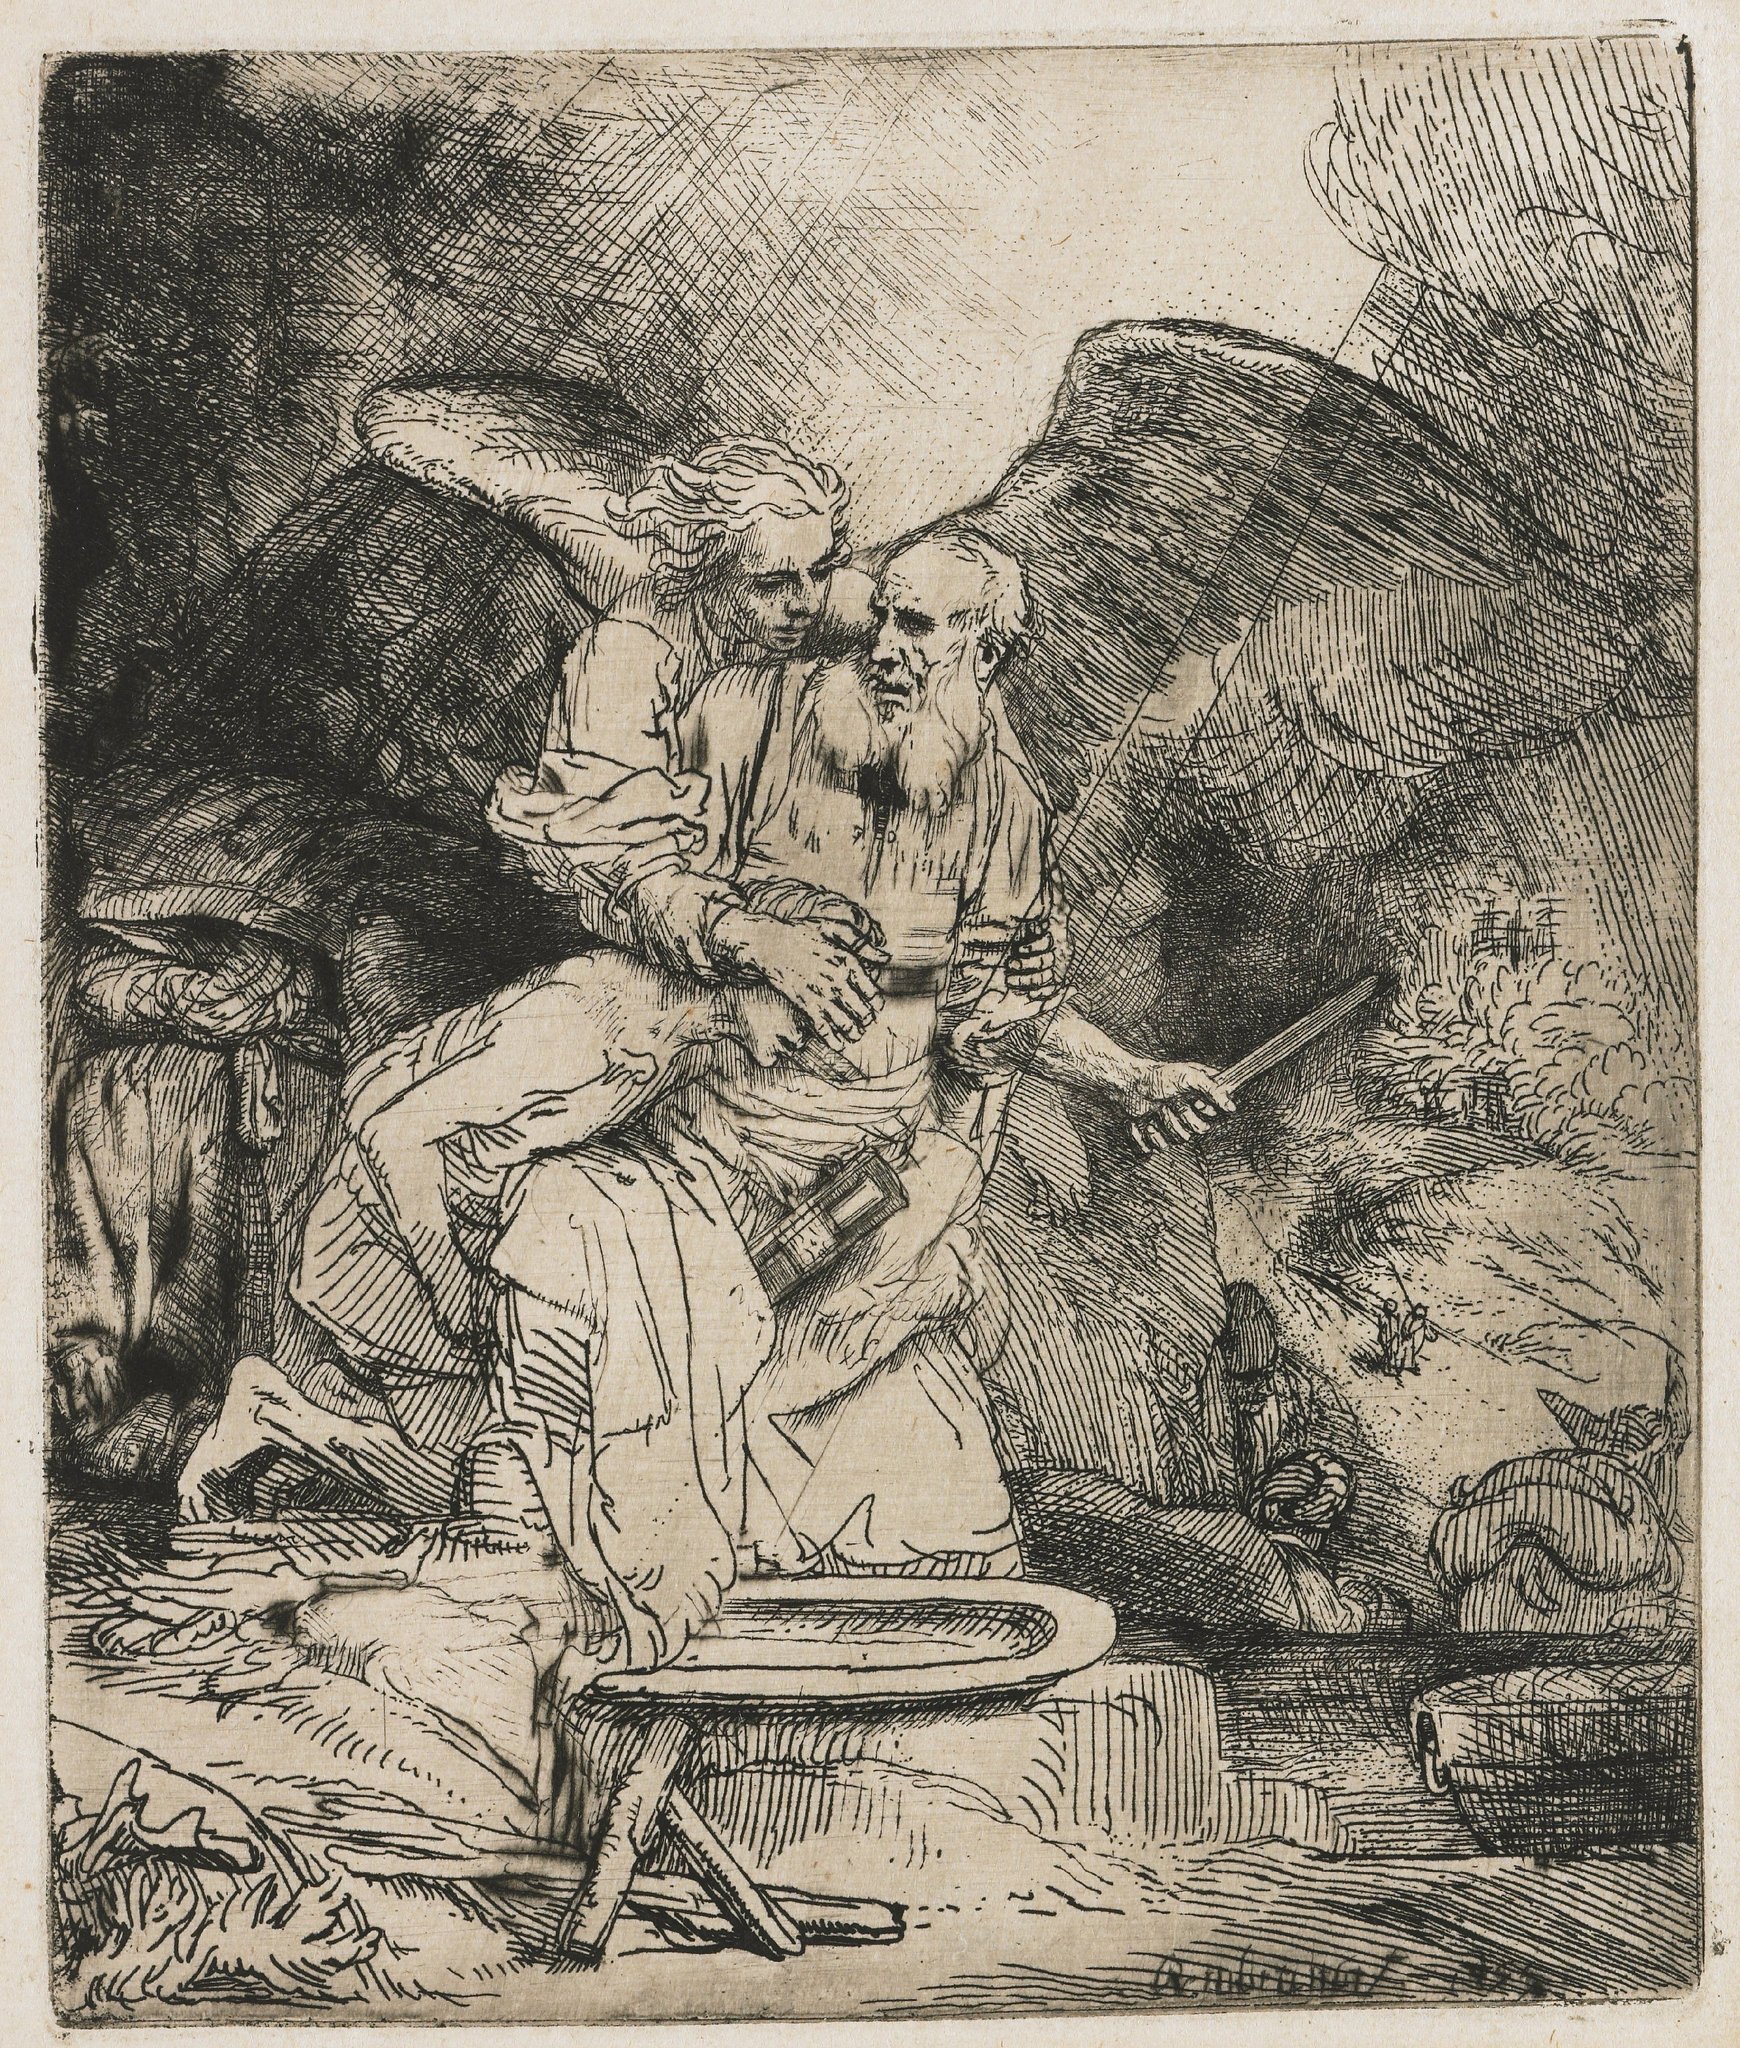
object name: print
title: Abraham's sacrifice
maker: rembrandt van rijn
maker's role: draughtsman, painter, print maker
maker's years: 1606-1669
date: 1655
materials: paper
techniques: drypoint, etching, intaglio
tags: story of abraham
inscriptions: mark: Lugt 240, signature and date: ‘Rembrandt f 1655’